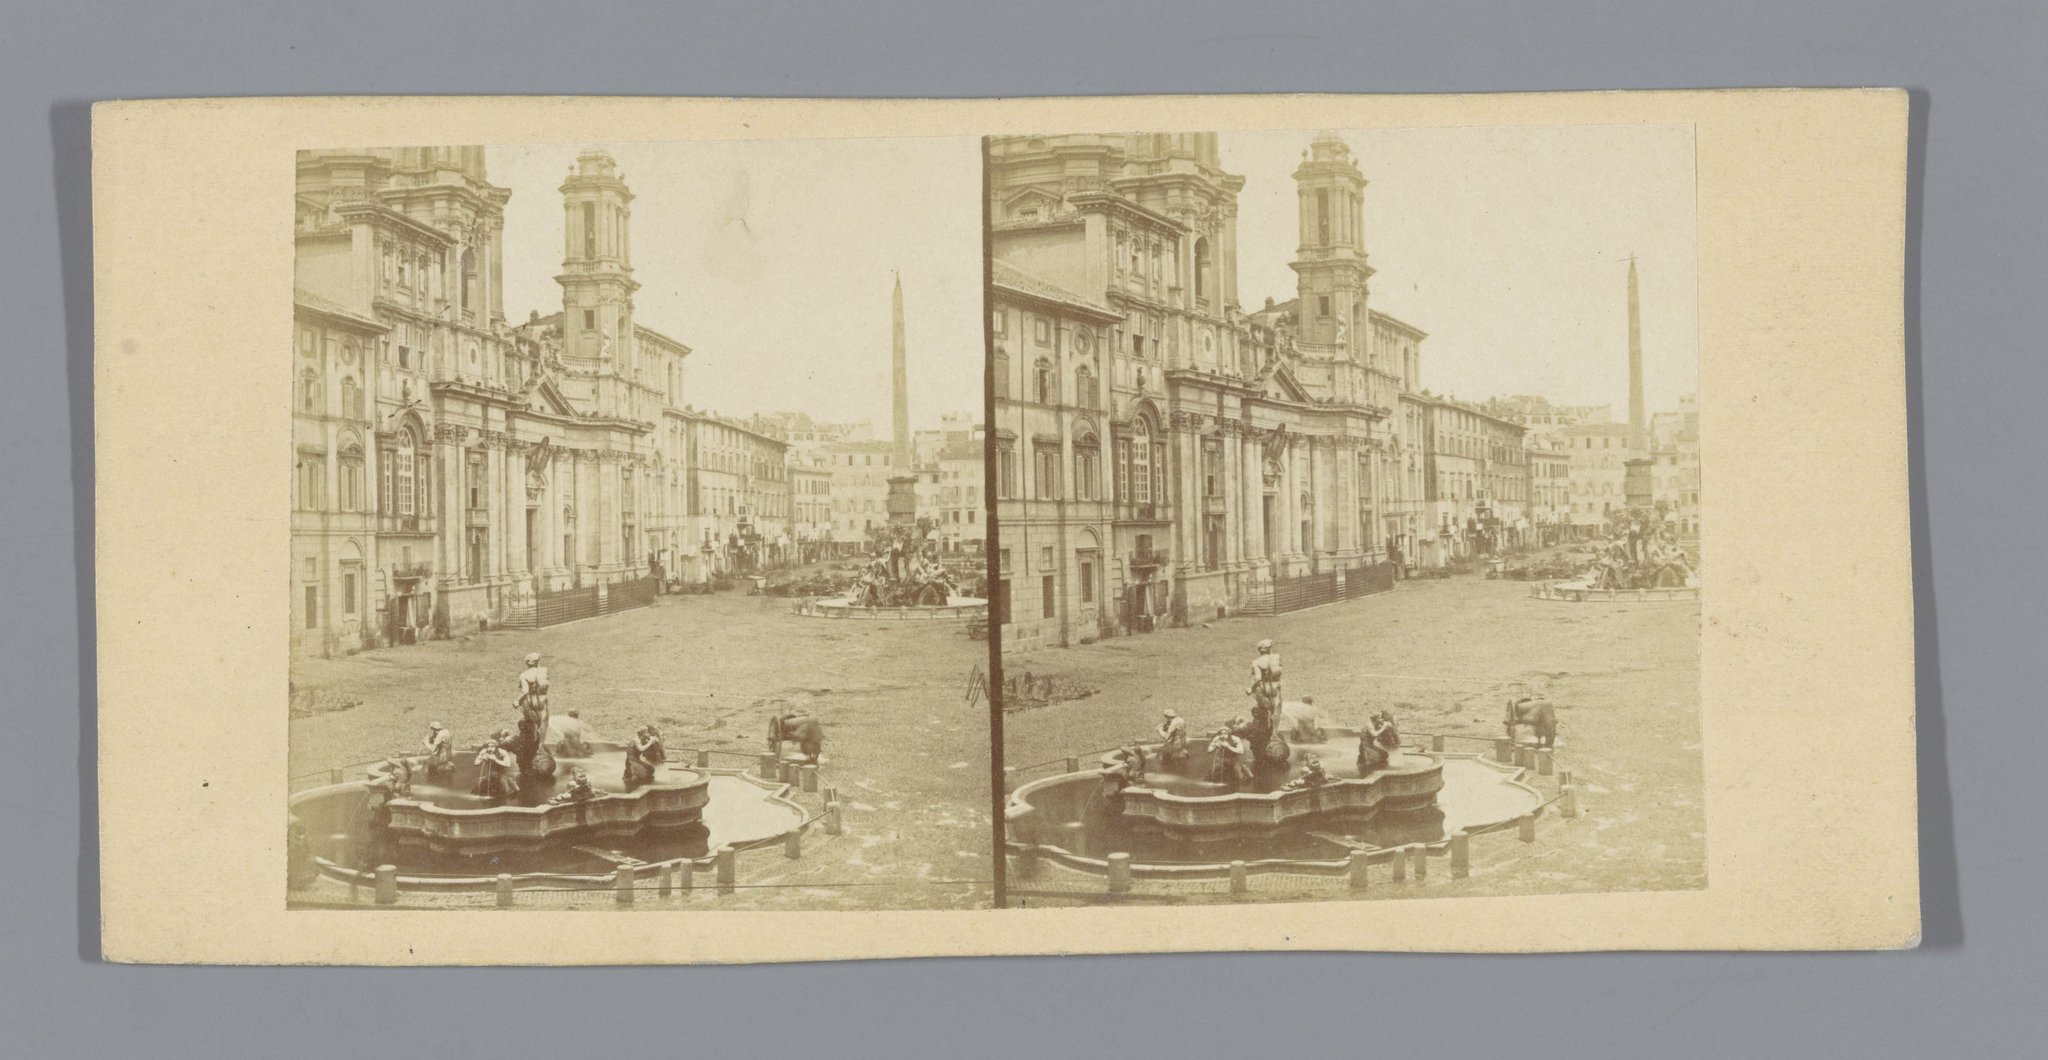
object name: stereograph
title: Piazza Navona te Rome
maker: Anonymous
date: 1850-1880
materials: cardboard, photographic support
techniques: albumen print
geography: piazza navona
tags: square, place, circus, etc., ornamental fountain, façade (of house or building)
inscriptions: number: ‘6’